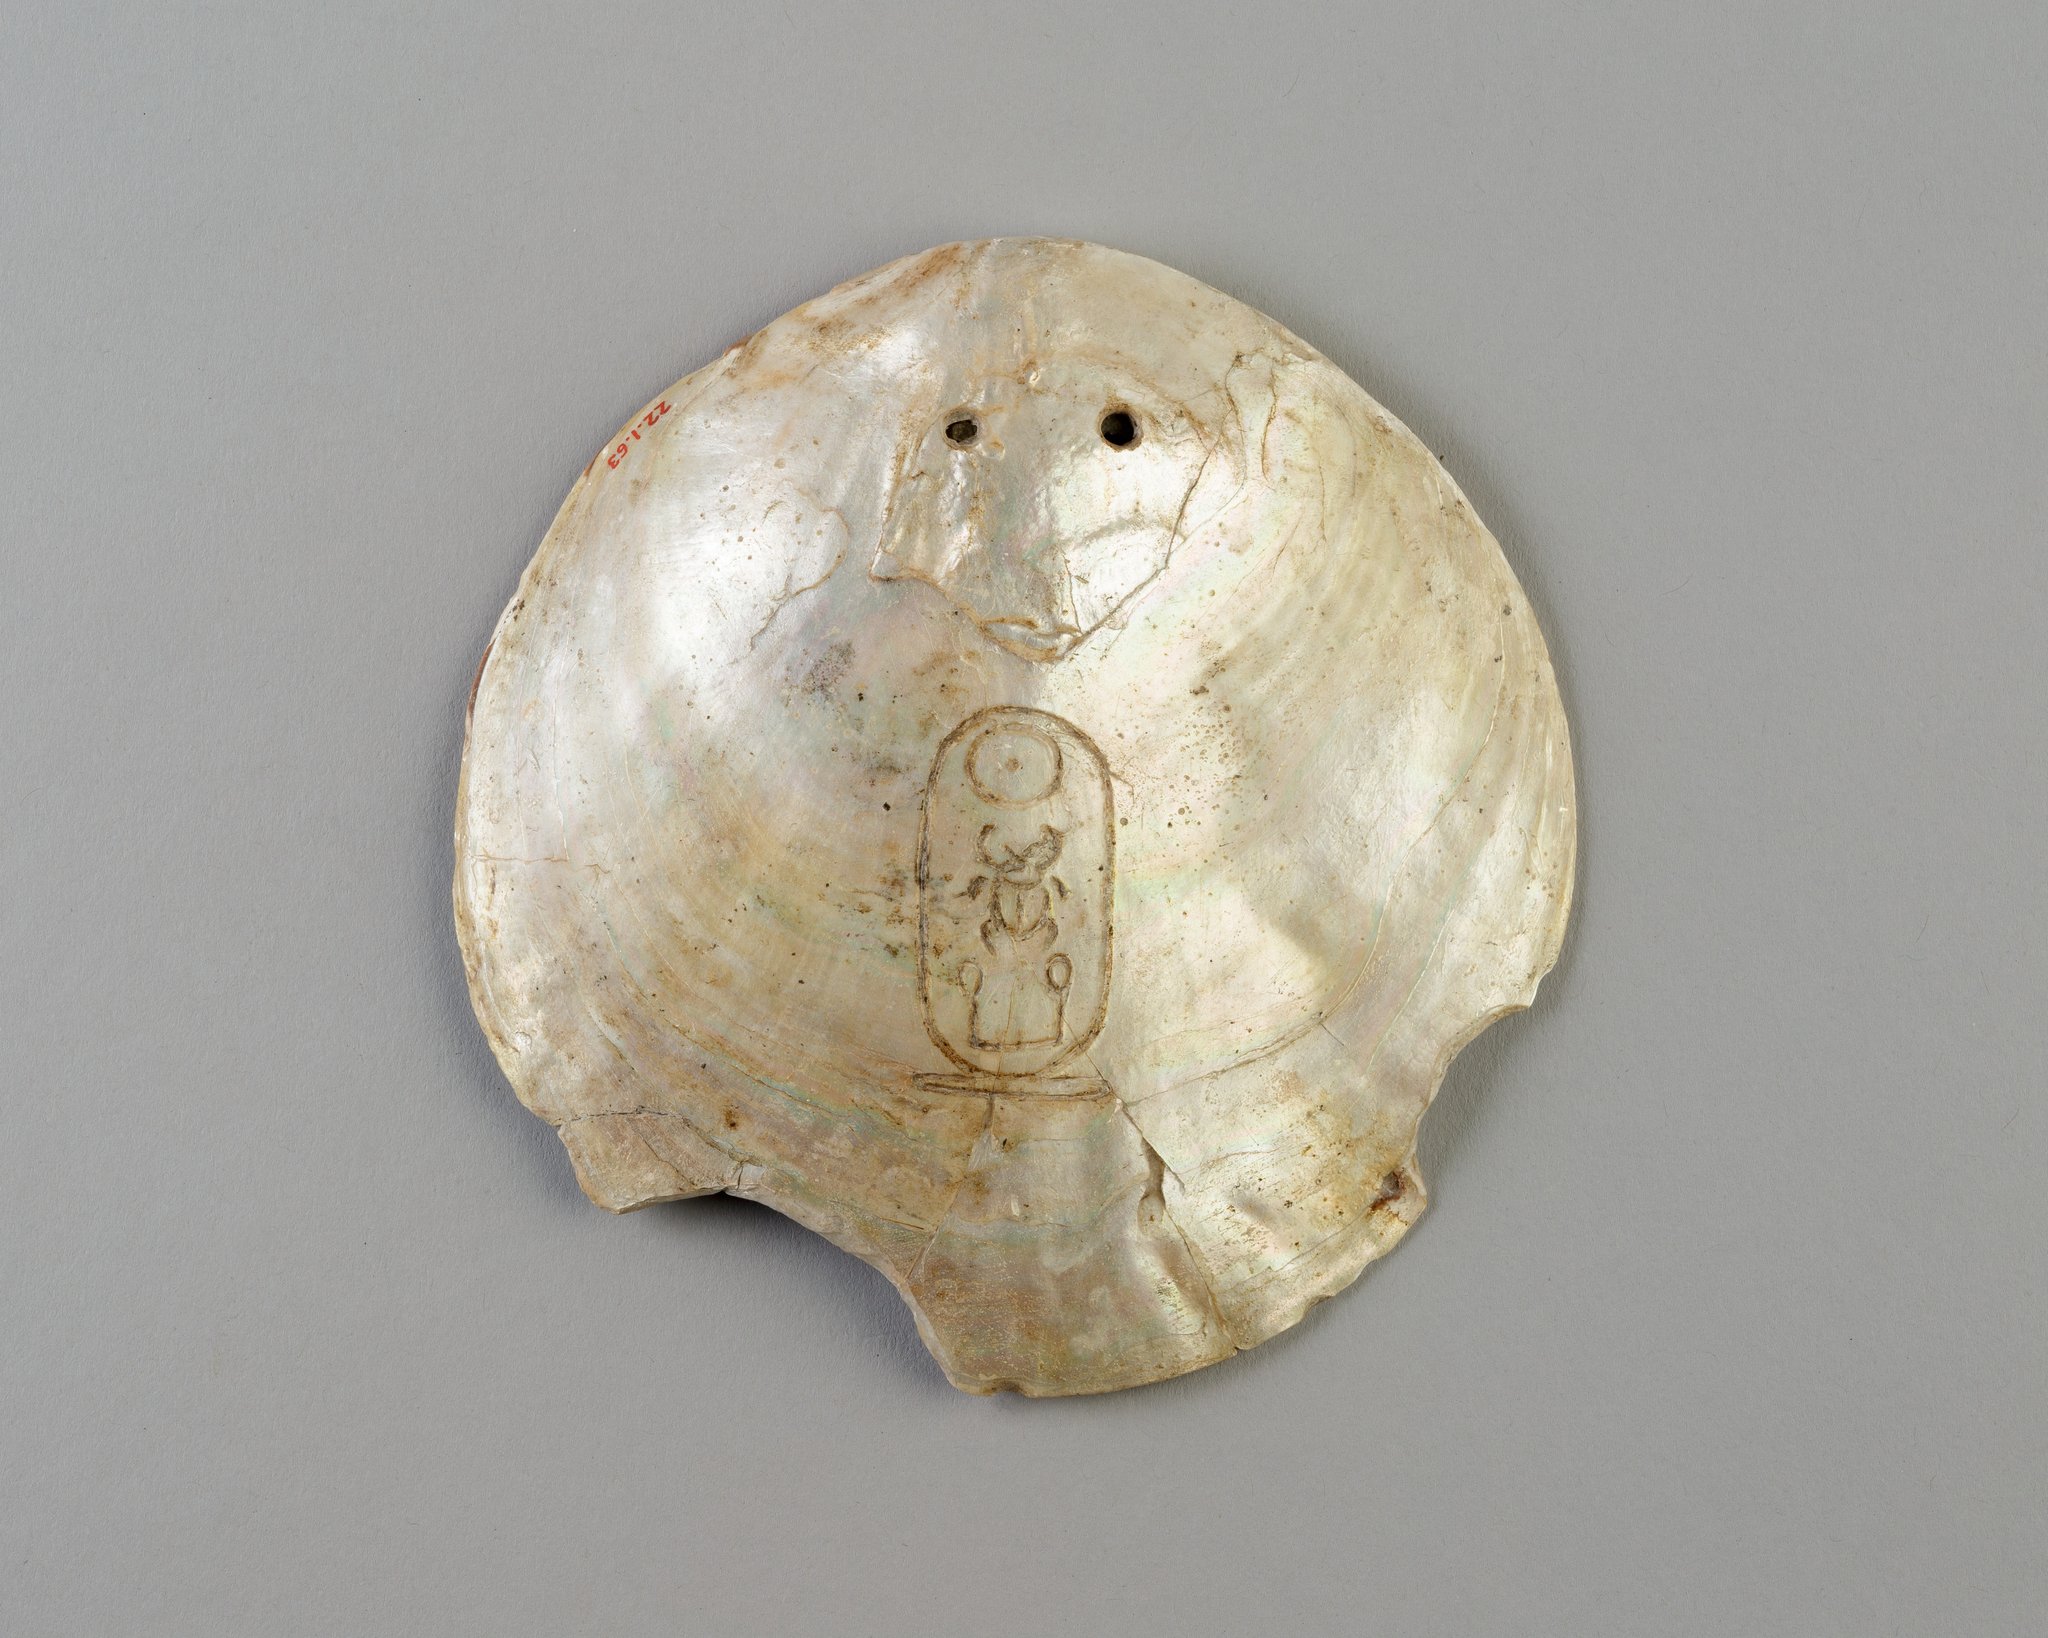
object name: shell, senwosret i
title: Shell Inscribed with the Cartouche of Senwosret I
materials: shell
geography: egypt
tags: cartouches